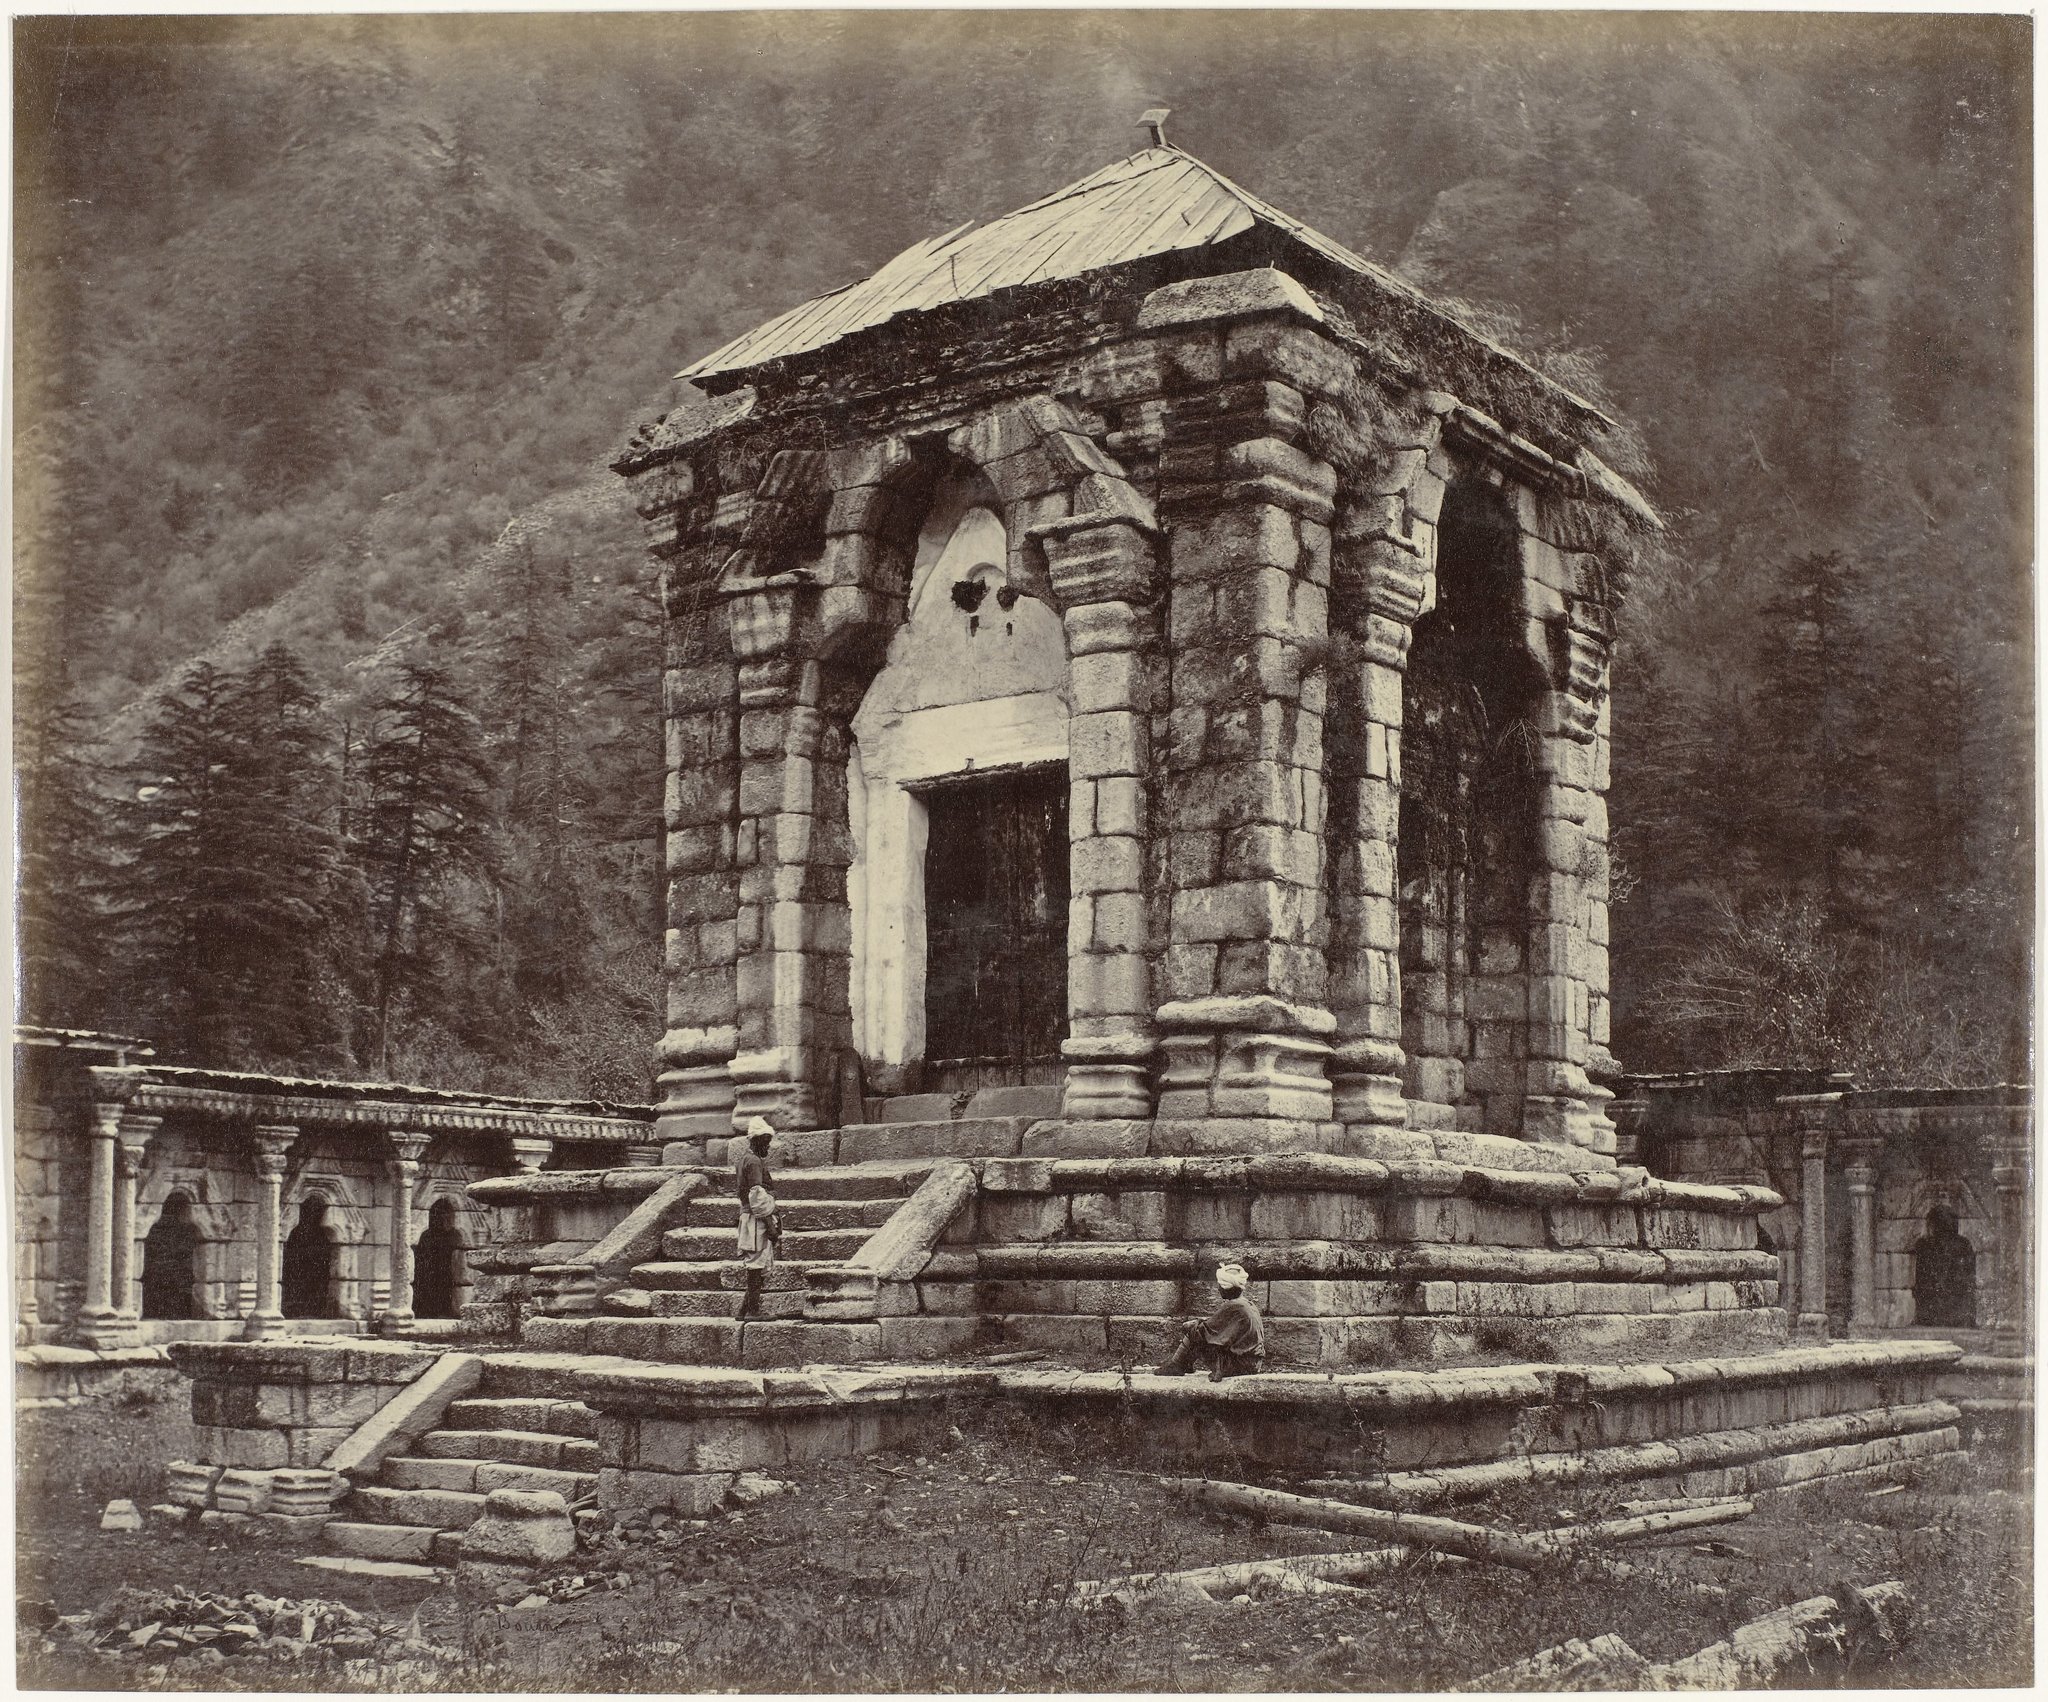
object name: photograph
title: Men at a temple in Buniyar, Jammu & Kashmir, India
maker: samuel bourne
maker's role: fotograaf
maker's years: 1834-1912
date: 1862-1864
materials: cardboard, paper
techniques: albumen print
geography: buniyar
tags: temple, shrine ~ hinduism, buddhism, jainism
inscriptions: number: ‘1000’, name: ‘Bourne’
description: For the pandits (scholars from the Hindu community of Kashmir and one of the indigenous peoples of that area), this is an emotionally charged image. This ancient temple, probably dedicated to the Hindu god Vishnu, attracted many photographers at the time. However, due to border tensions after the partition of British India, the area is today guarded by the military and therefore very difficult for the people to access.